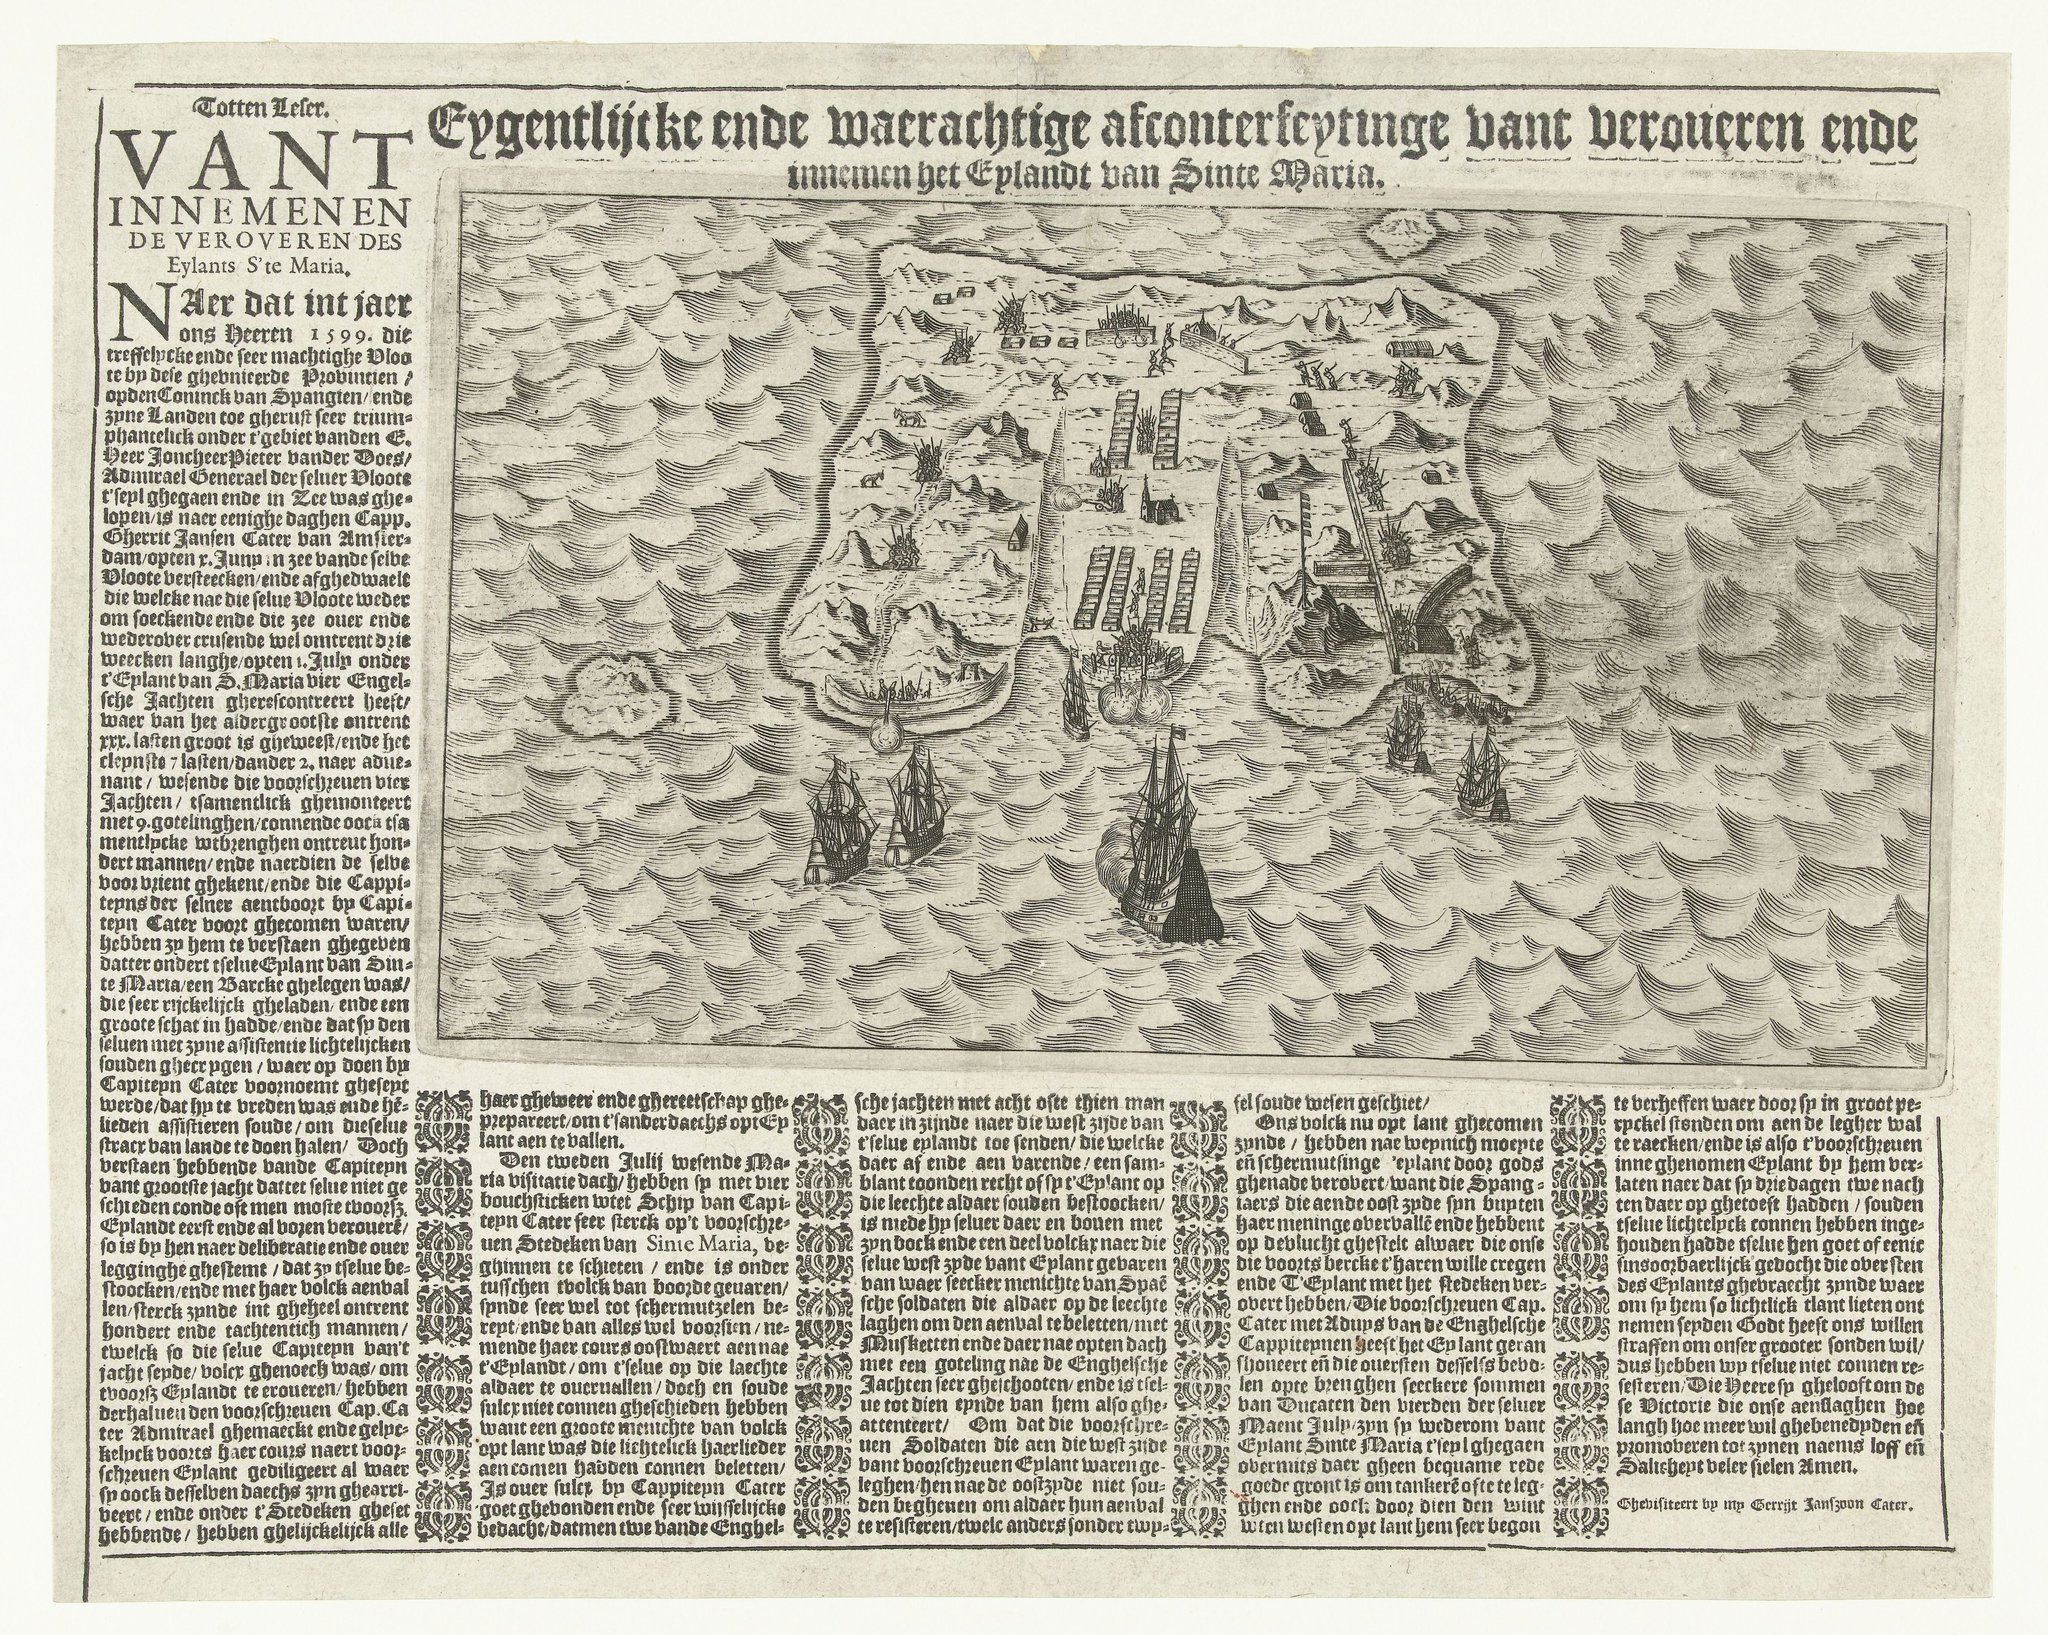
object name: print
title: Verovering van het eiland Santa Maria door kapitien Gerrit Jansen Cater, 1599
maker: Anonymous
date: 1599-1601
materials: paper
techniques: engraving, letterpress printing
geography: northern netherlands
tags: battle (+ naval force)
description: Verovering van het eiland Santa Maria in de Azoren door kapitien Gerrit Jansen Cater, 2 juli 1599. Het schip van Cater samen met vier kleine Engelse schepen voor het eiland. Om de voorstelling een beschrijving van de gebeurtenissen in 5 kolommen in het Nederlands.